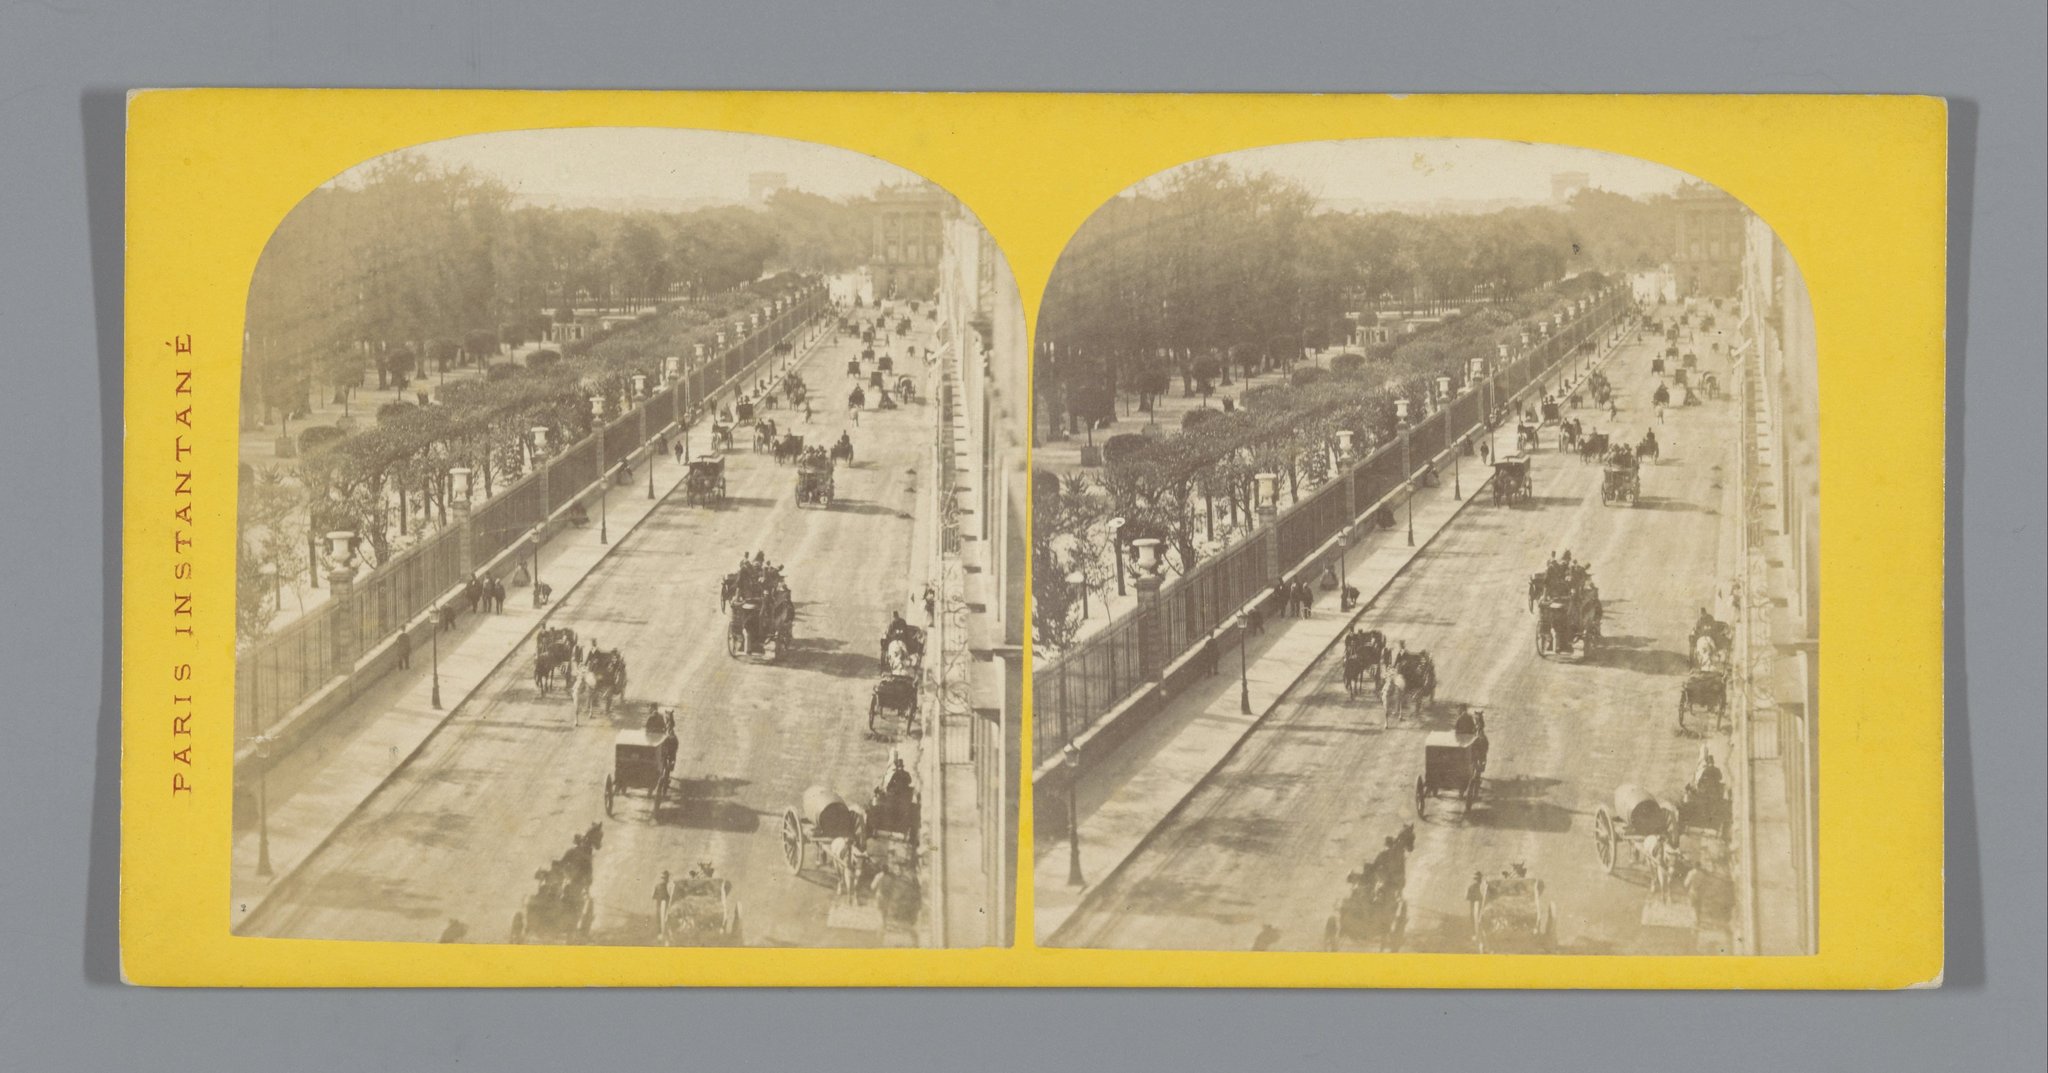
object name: stereograph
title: Gezicht op een straat met rijtuigen te Parijs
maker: jouve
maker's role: fotograaf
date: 1850-1875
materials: cardboard, photographic support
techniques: albumen print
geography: paris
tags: four-wheeled, animal-drawn vehicle, e.g.: cab, carriage, coach, avenue, boulevard, promenade, esplanade, paris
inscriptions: inscription: ‘Foto: Jouve 1862/70 (inl. dans les rues de paris au temps des fiacres)’, inscription: ‘Paris instantané’